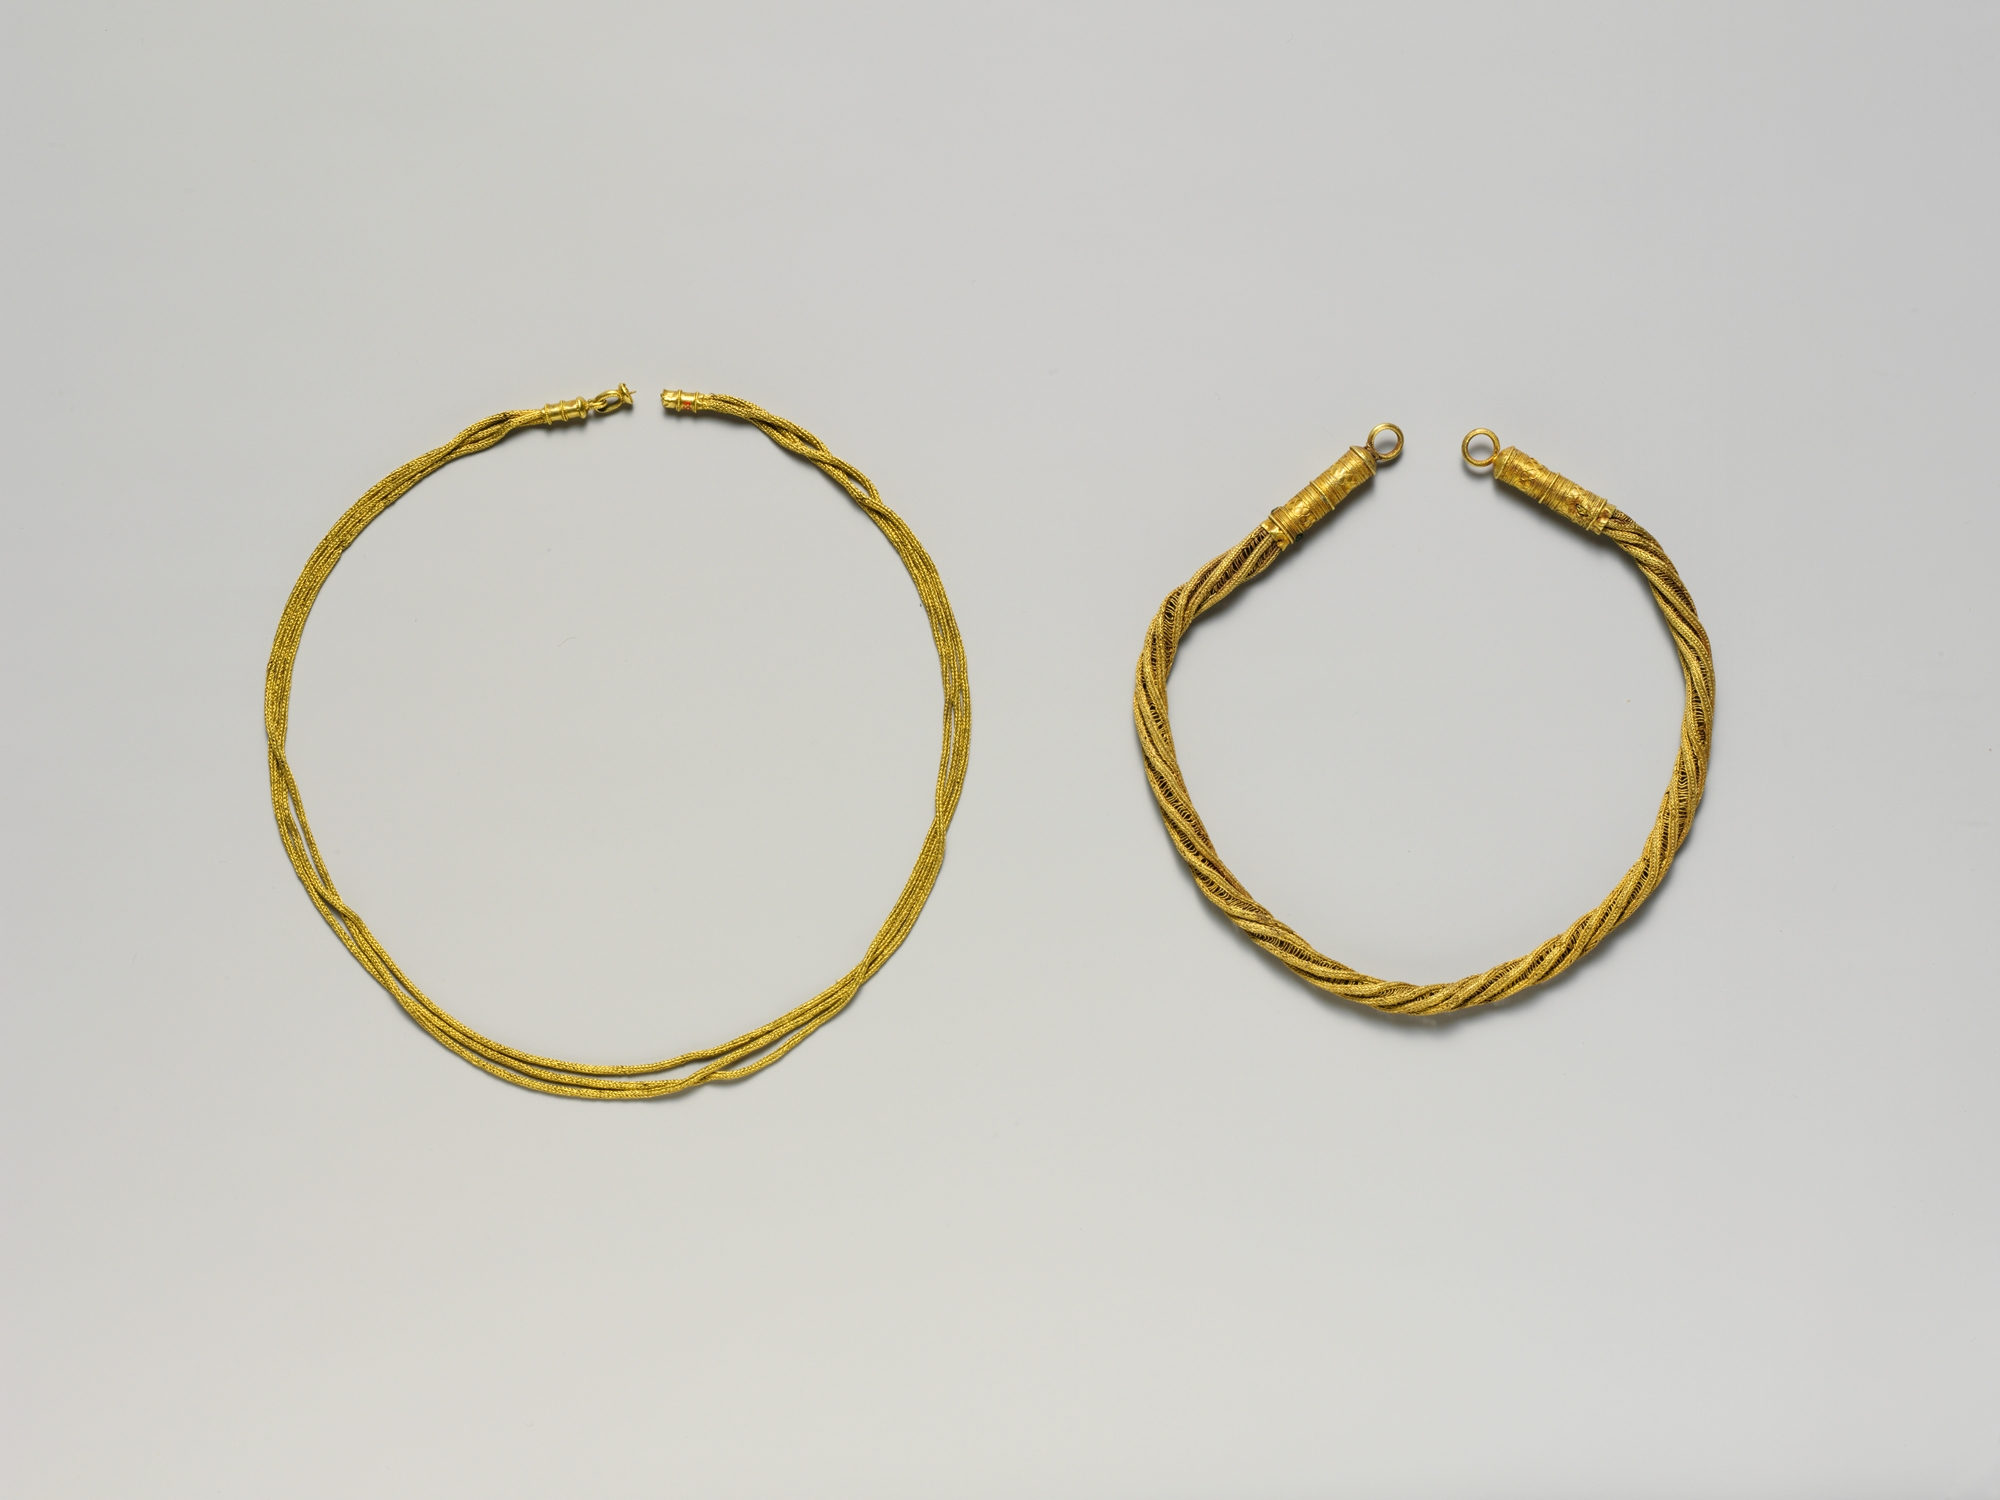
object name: necklace, chain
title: Gold necklace of linked strands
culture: etruscan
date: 300-301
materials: gold